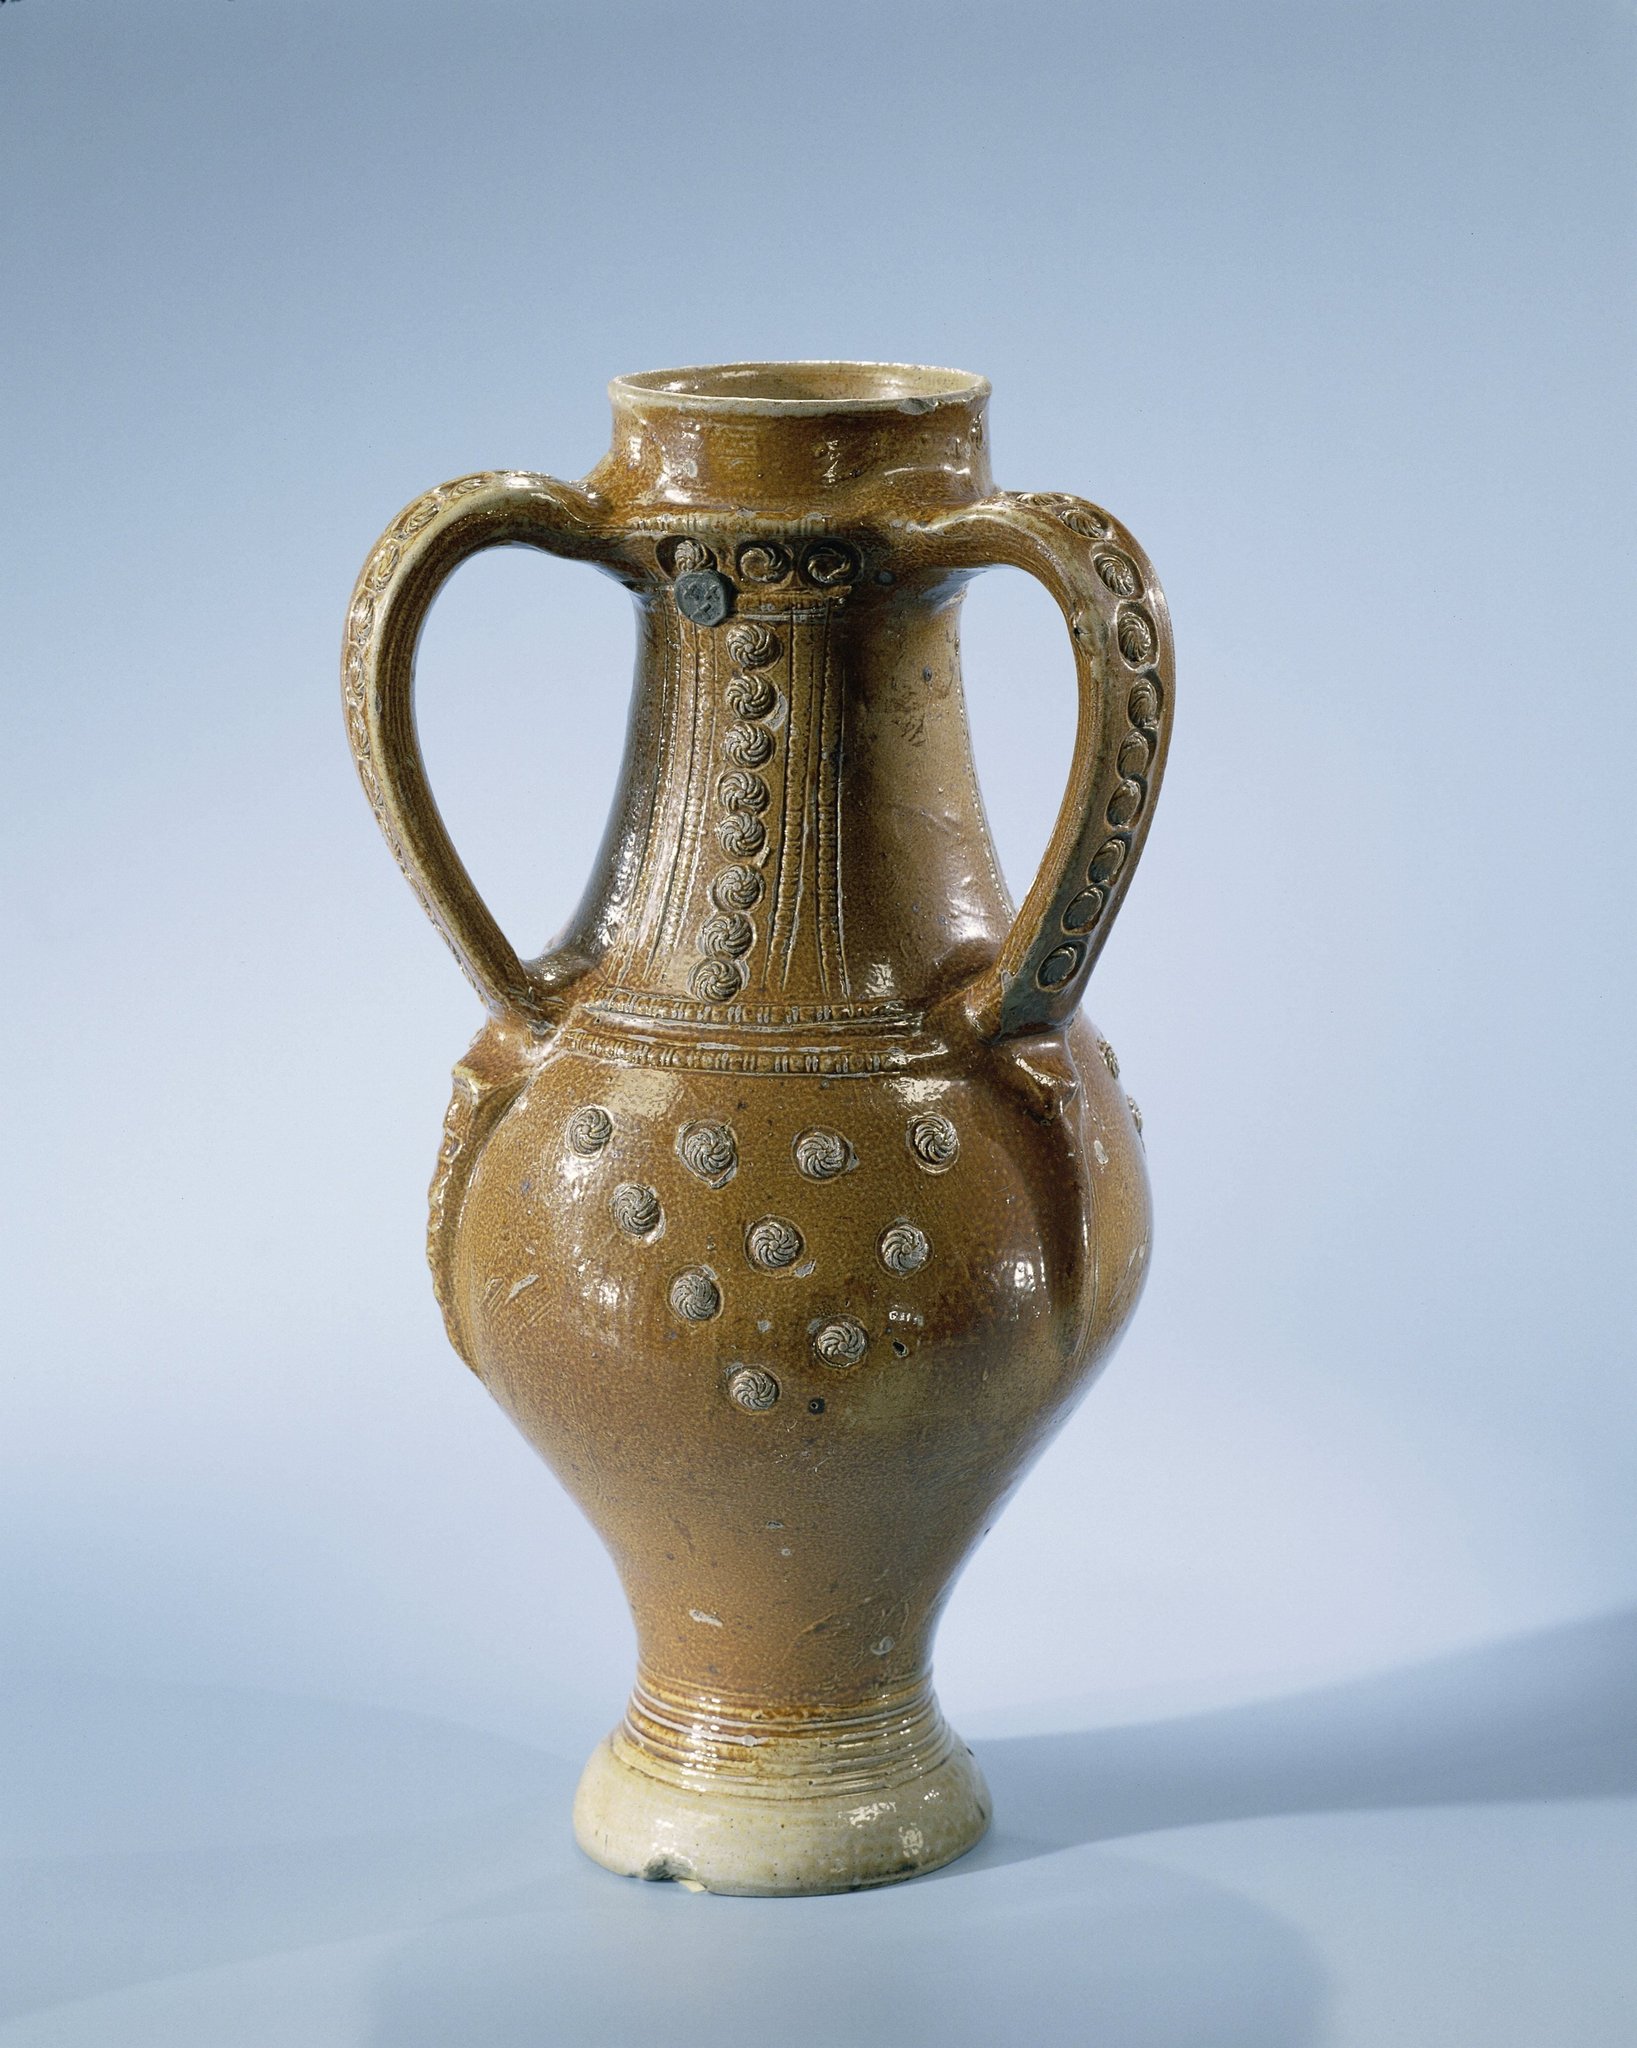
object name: ewer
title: Jug with three handles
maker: Anonymous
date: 1590-1600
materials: engobe, glaze, lead, stoneware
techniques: firing, forming, relief, turning, vitrification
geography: raeren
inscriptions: mark: ‘XXX’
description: Stoneware with pewter mounts. Jug with three handles. Raeren, c. 1590 - 1600.